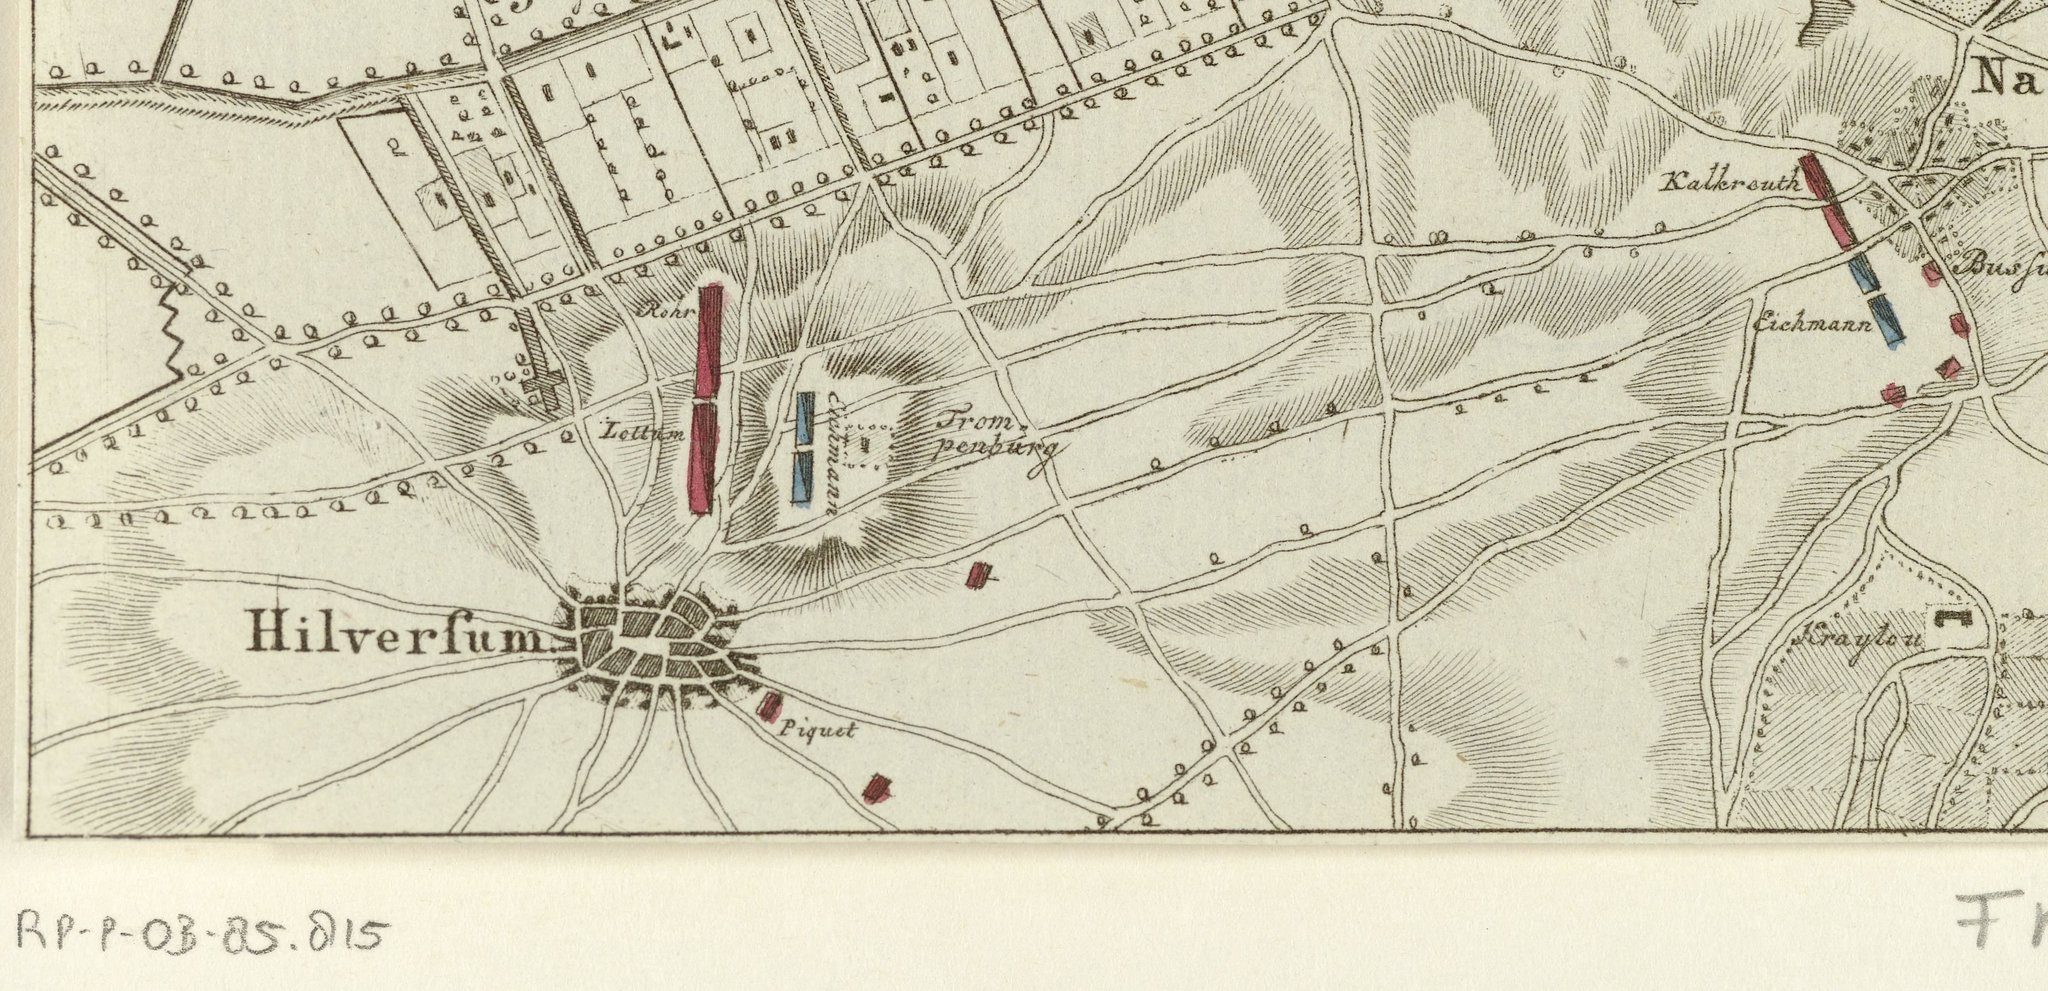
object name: print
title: Kampement van de Pruisen te Hilversum, 1787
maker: Anonymous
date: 1790-1792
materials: paper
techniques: etching, hand coloring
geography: northern netherlands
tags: maps of cities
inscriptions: collector's mark: Lugt 2228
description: Kaart met de ligging van het kampement van de Pruisische troepen bij Hilversum op 18 september 1787. Onderdeel van een groep van veertien genummerde kaartjes van de kampementen van de Pruisische troepen tijdens de interventie in de Nederlanden in september 1787.